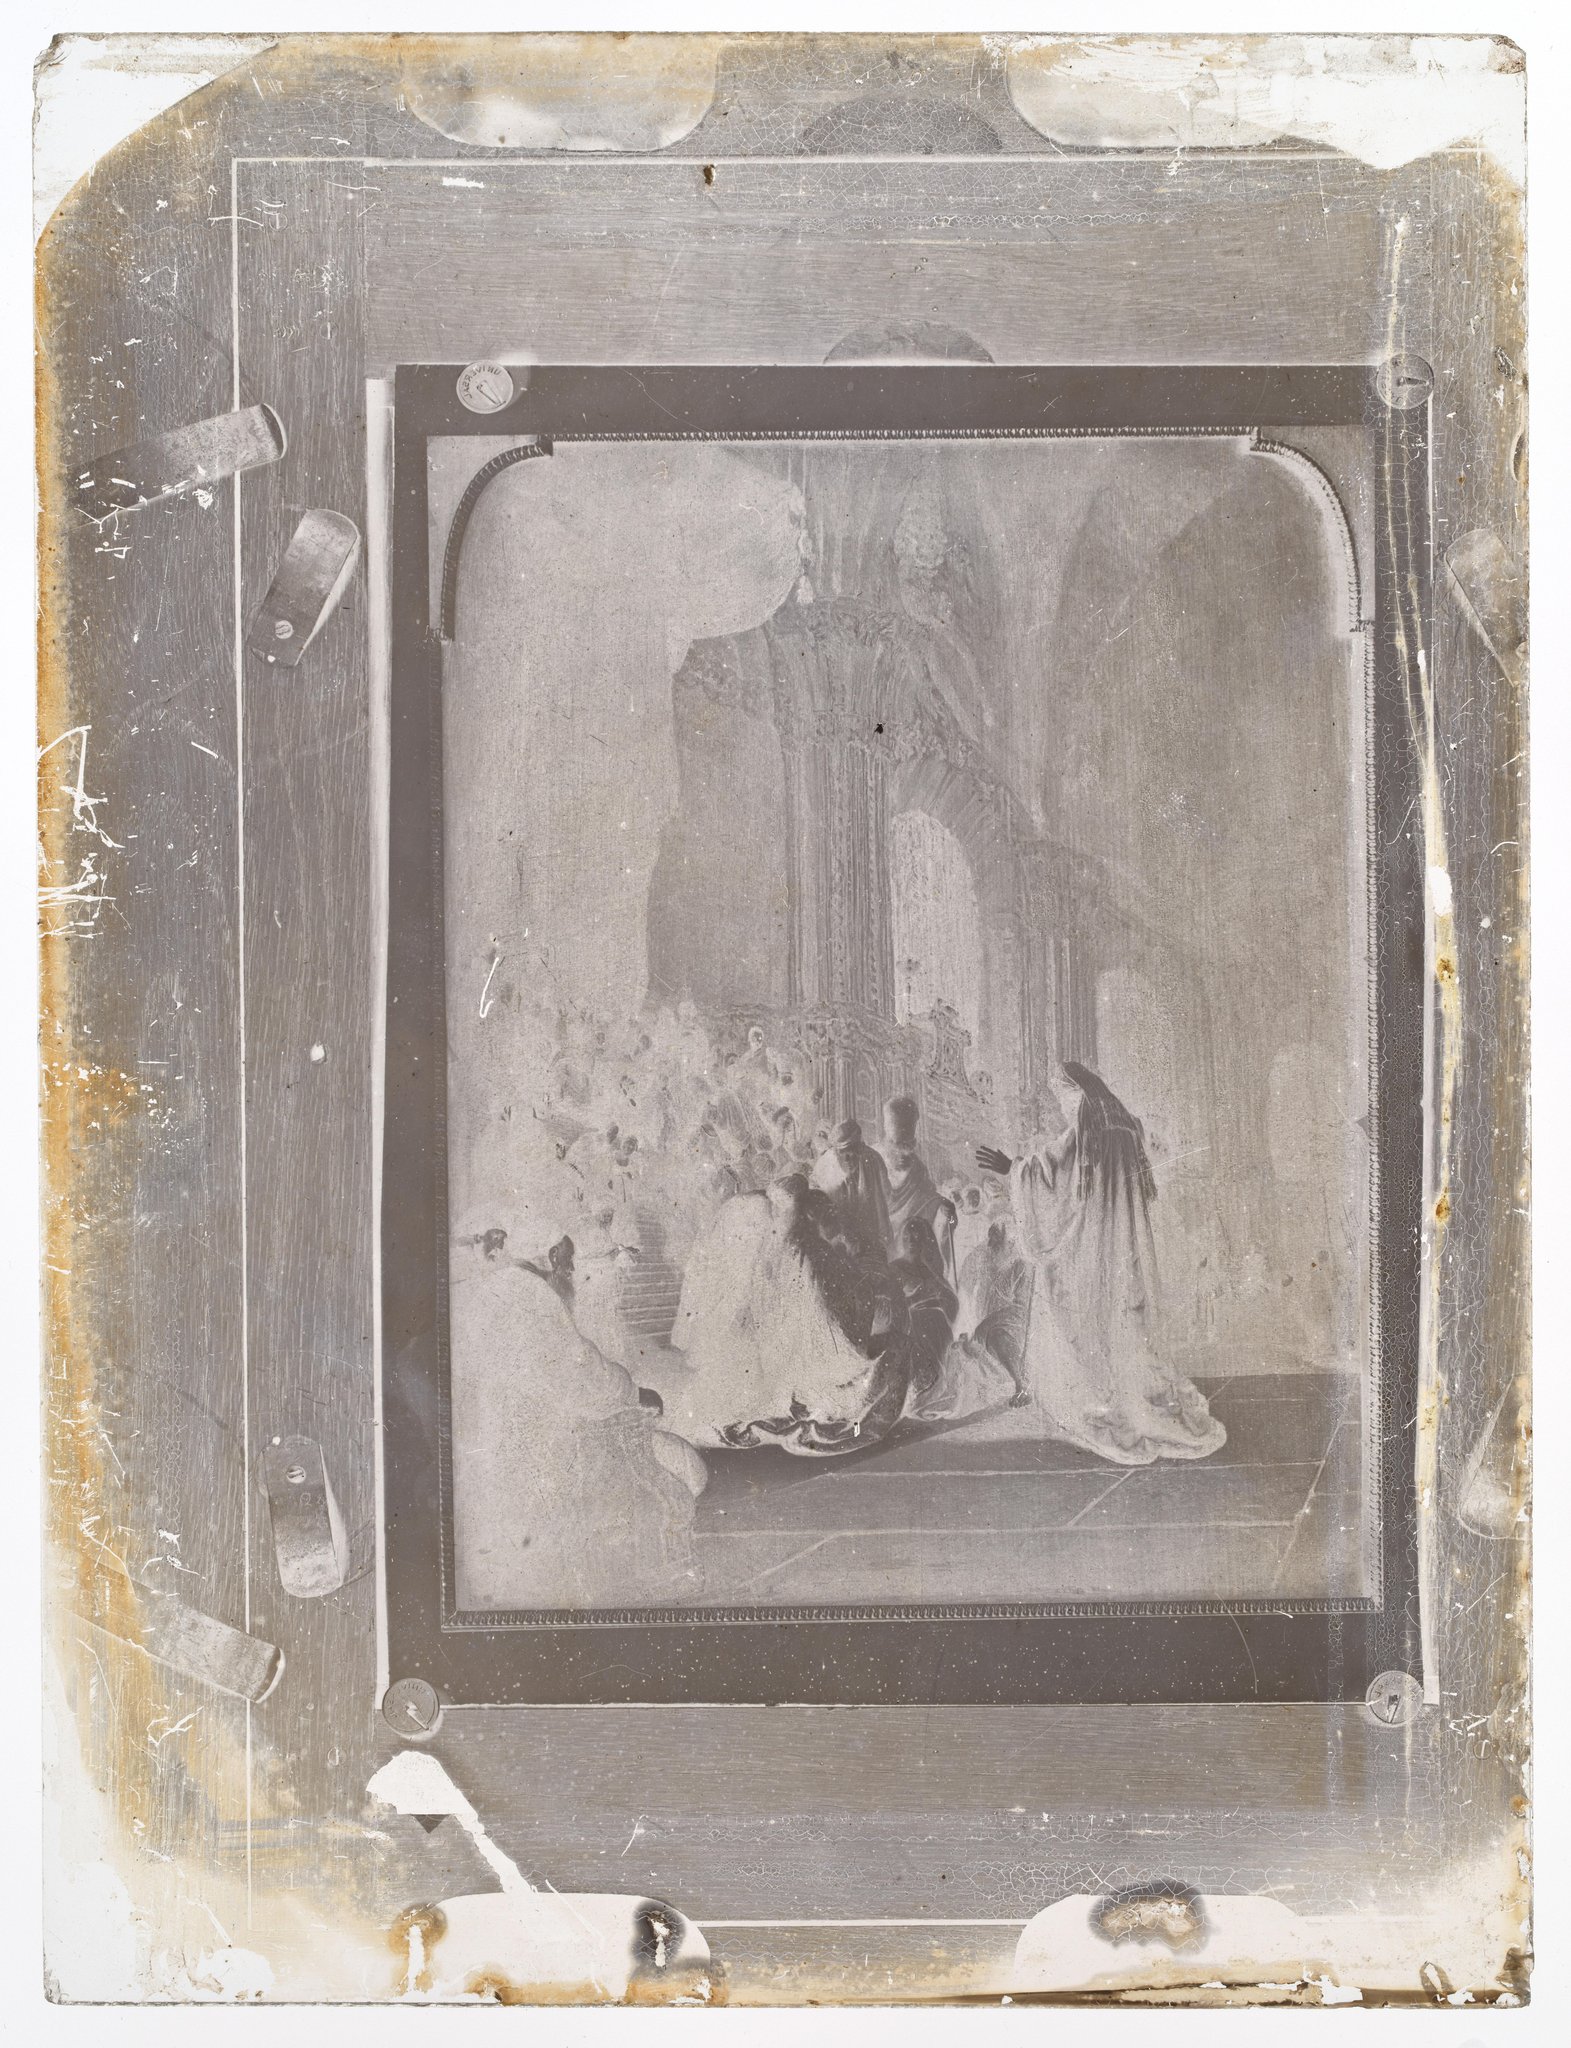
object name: glasnegatief, glasplaatnegatief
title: Fotoreproductie van een schilderij van een Bijbelse scène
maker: Anonymous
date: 1880-1930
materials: glass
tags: interior of church